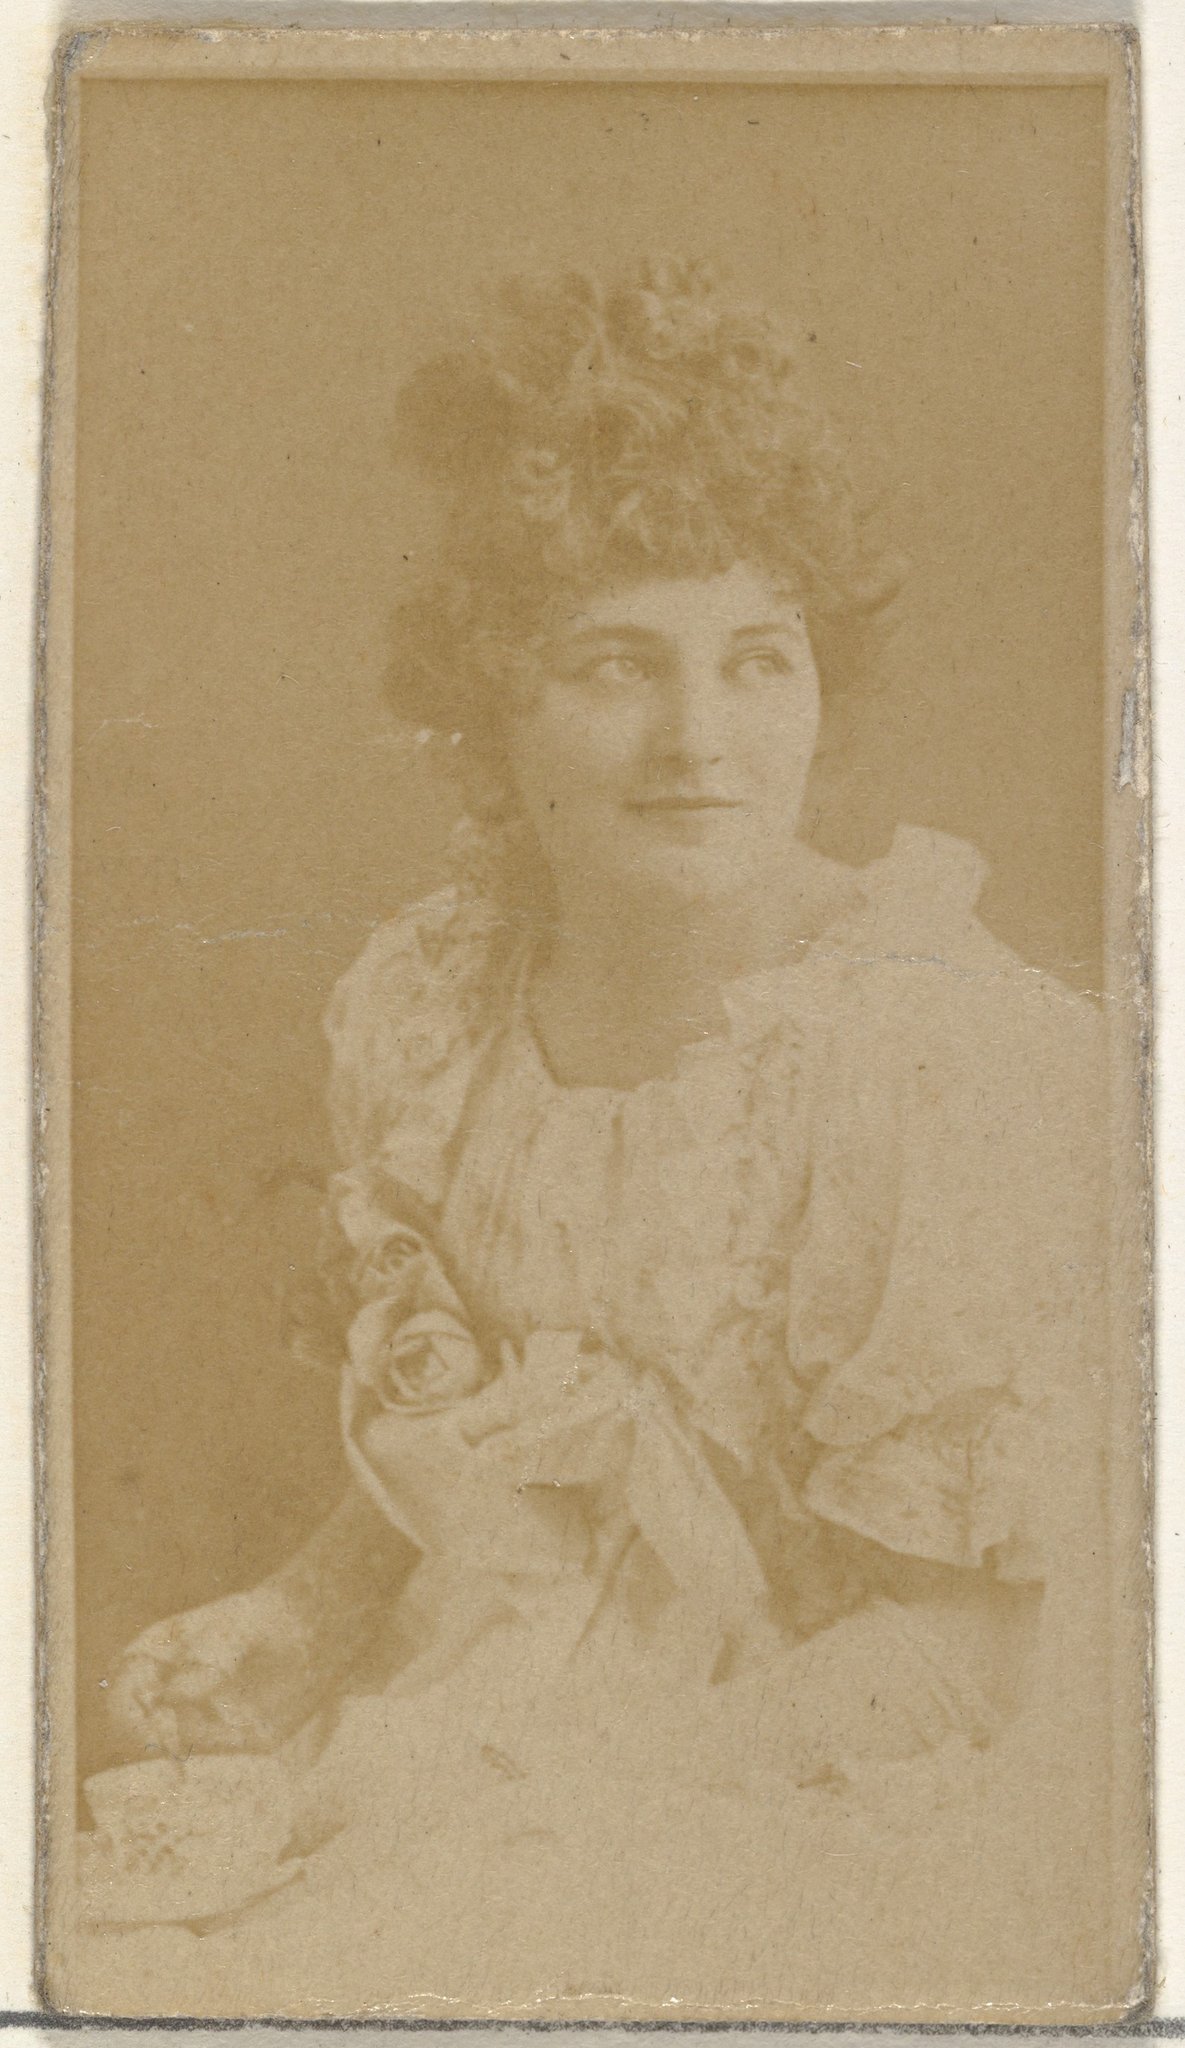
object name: photograph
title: [Actress holding teacup], from the Actors and Actresses series (N145-8) issued by Duke Sons & Co. to promote Duke Cigarettes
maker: w. duke, sons & co.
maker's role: publisher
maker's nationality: american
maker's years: 1870-1920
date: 1891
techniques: albumen silver print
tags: portraits,women,actresses